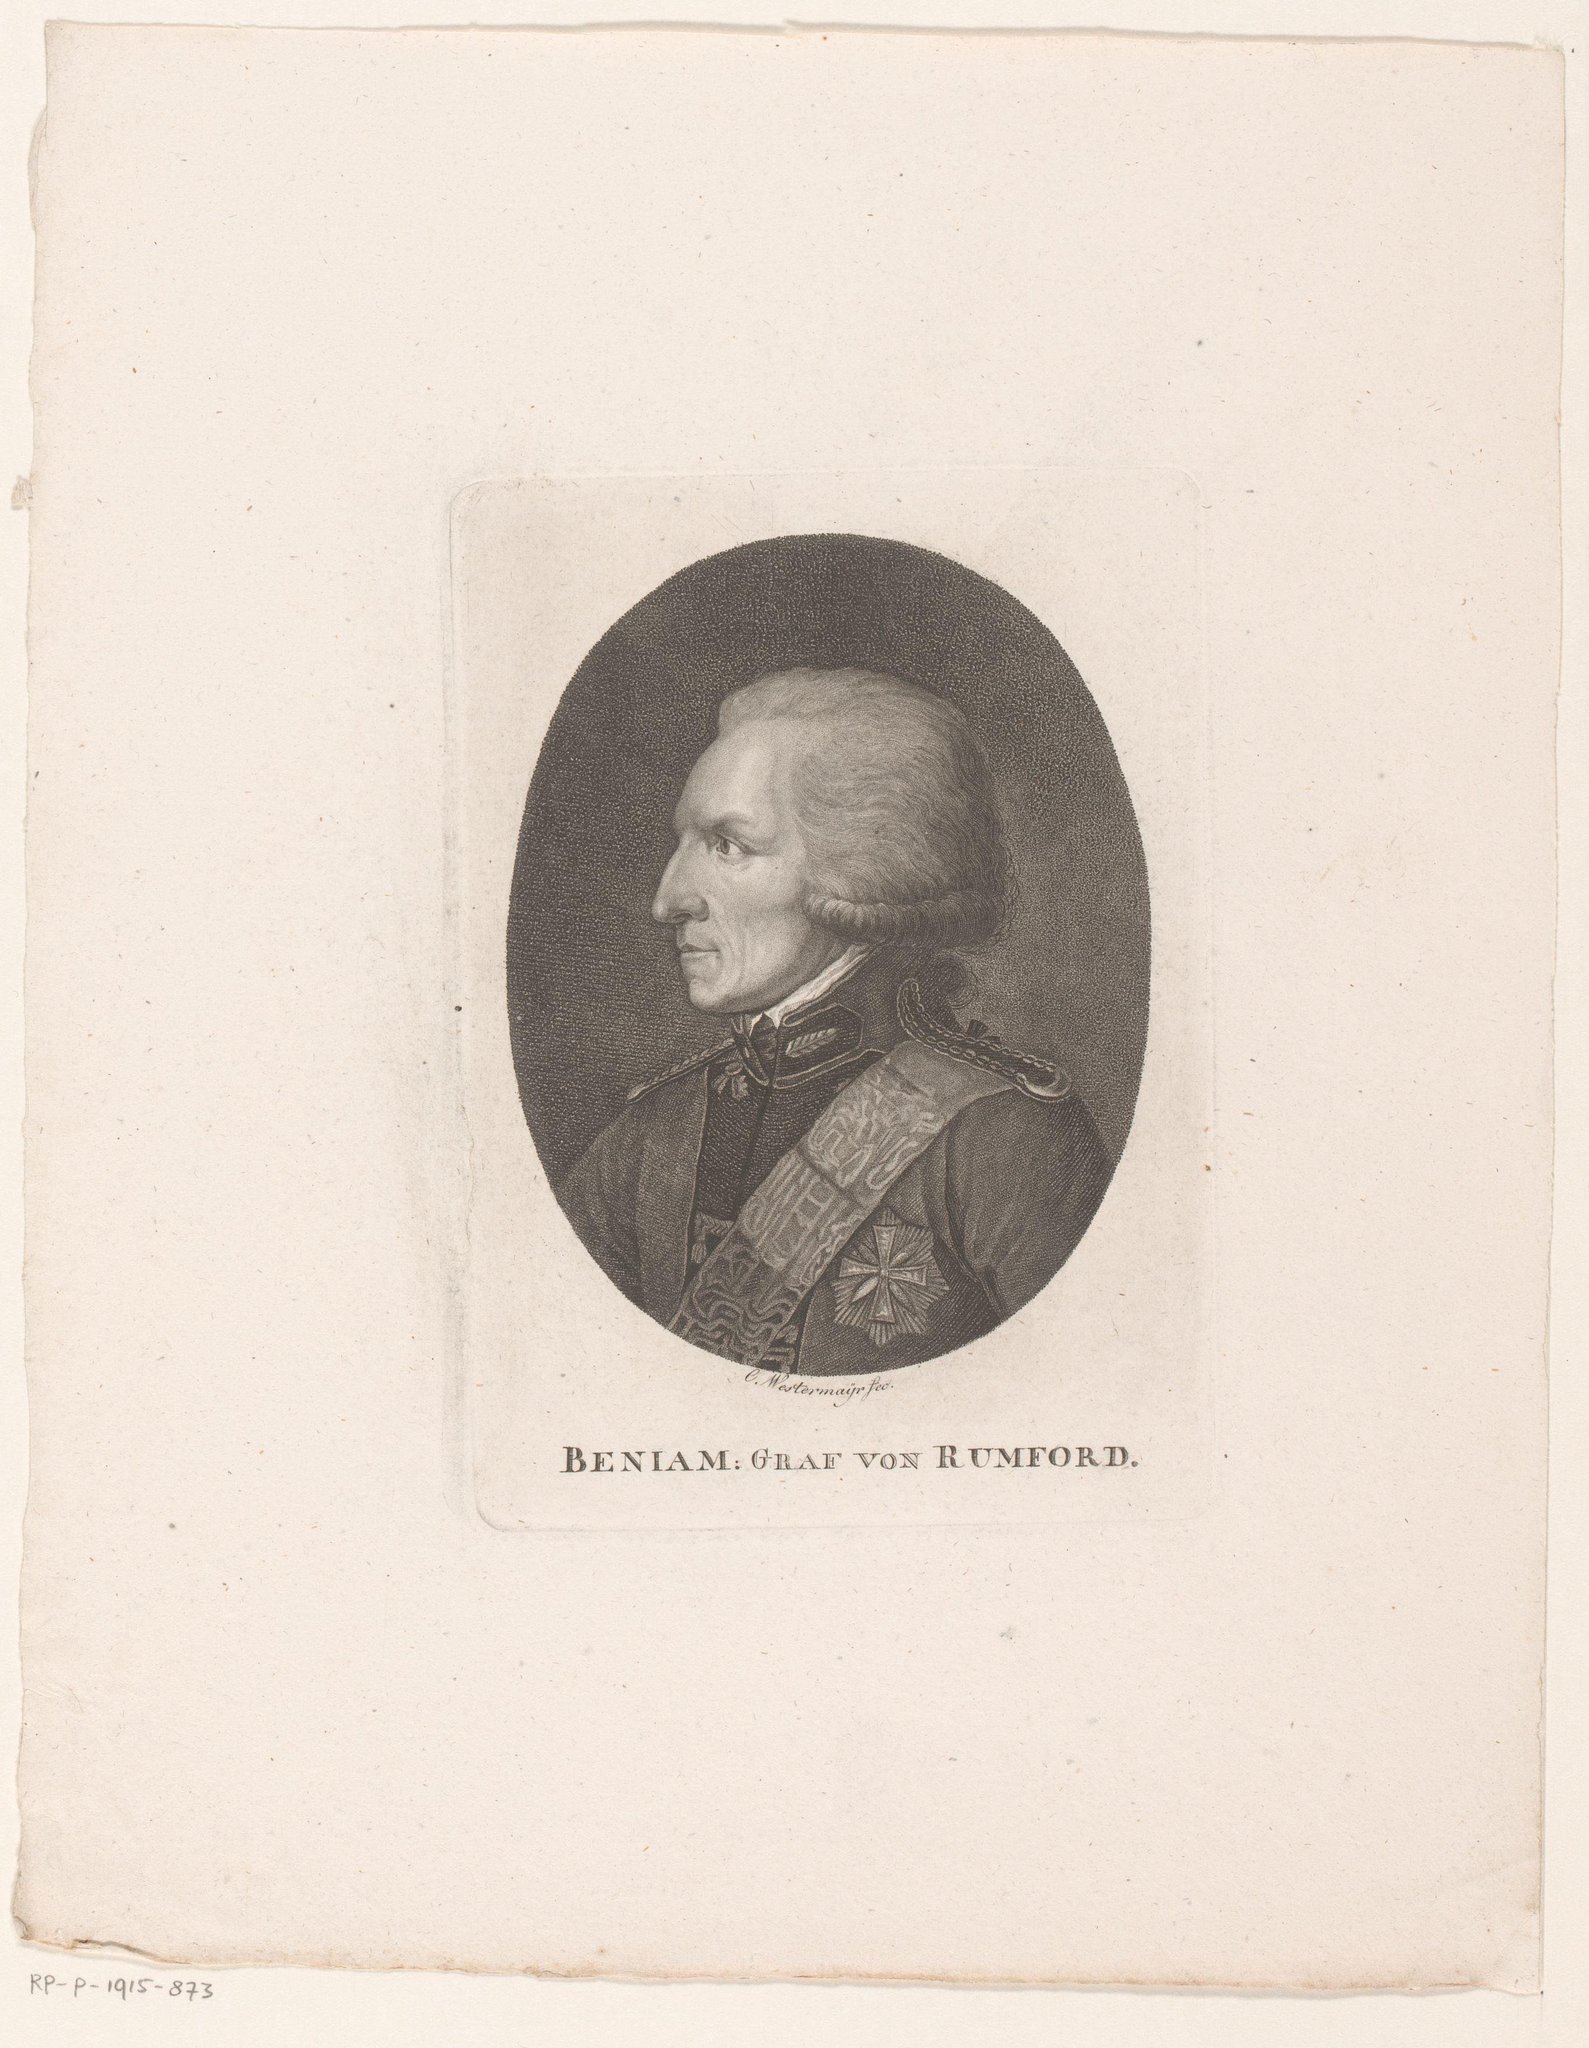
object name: print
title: Portret van Benjamin Thompson von Rumford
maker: konrad westermayr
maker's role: print maker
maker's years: 1765-1834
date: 1775-1834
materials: paper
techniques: engraving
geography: germany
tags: united states of america, paris, historical persons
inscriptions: collector's mark: Lugt 2228